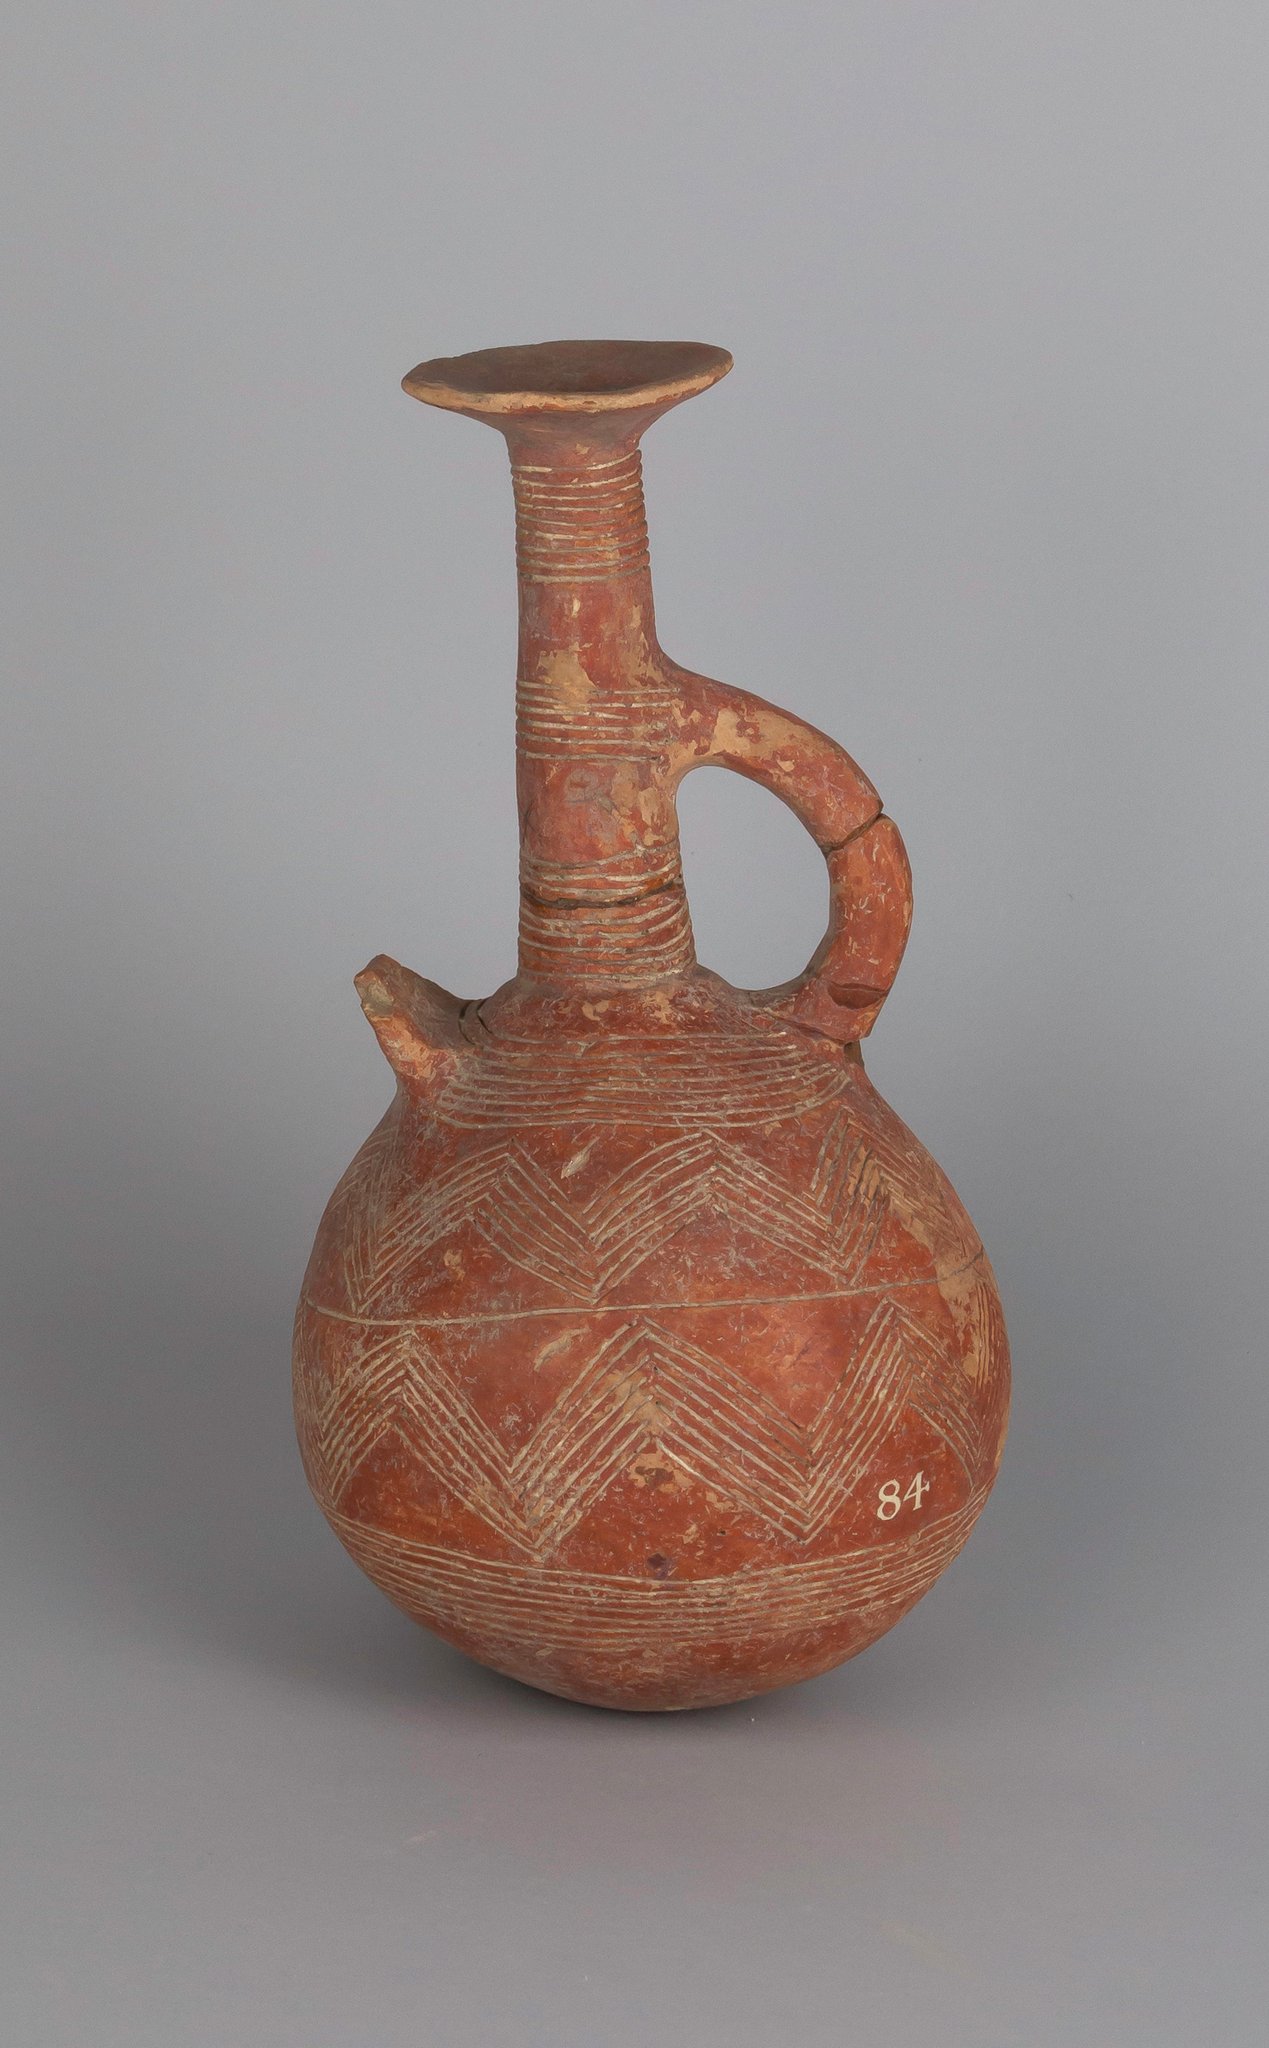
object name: jug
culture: cypriot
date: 2500-1900 BCE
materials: terracotta